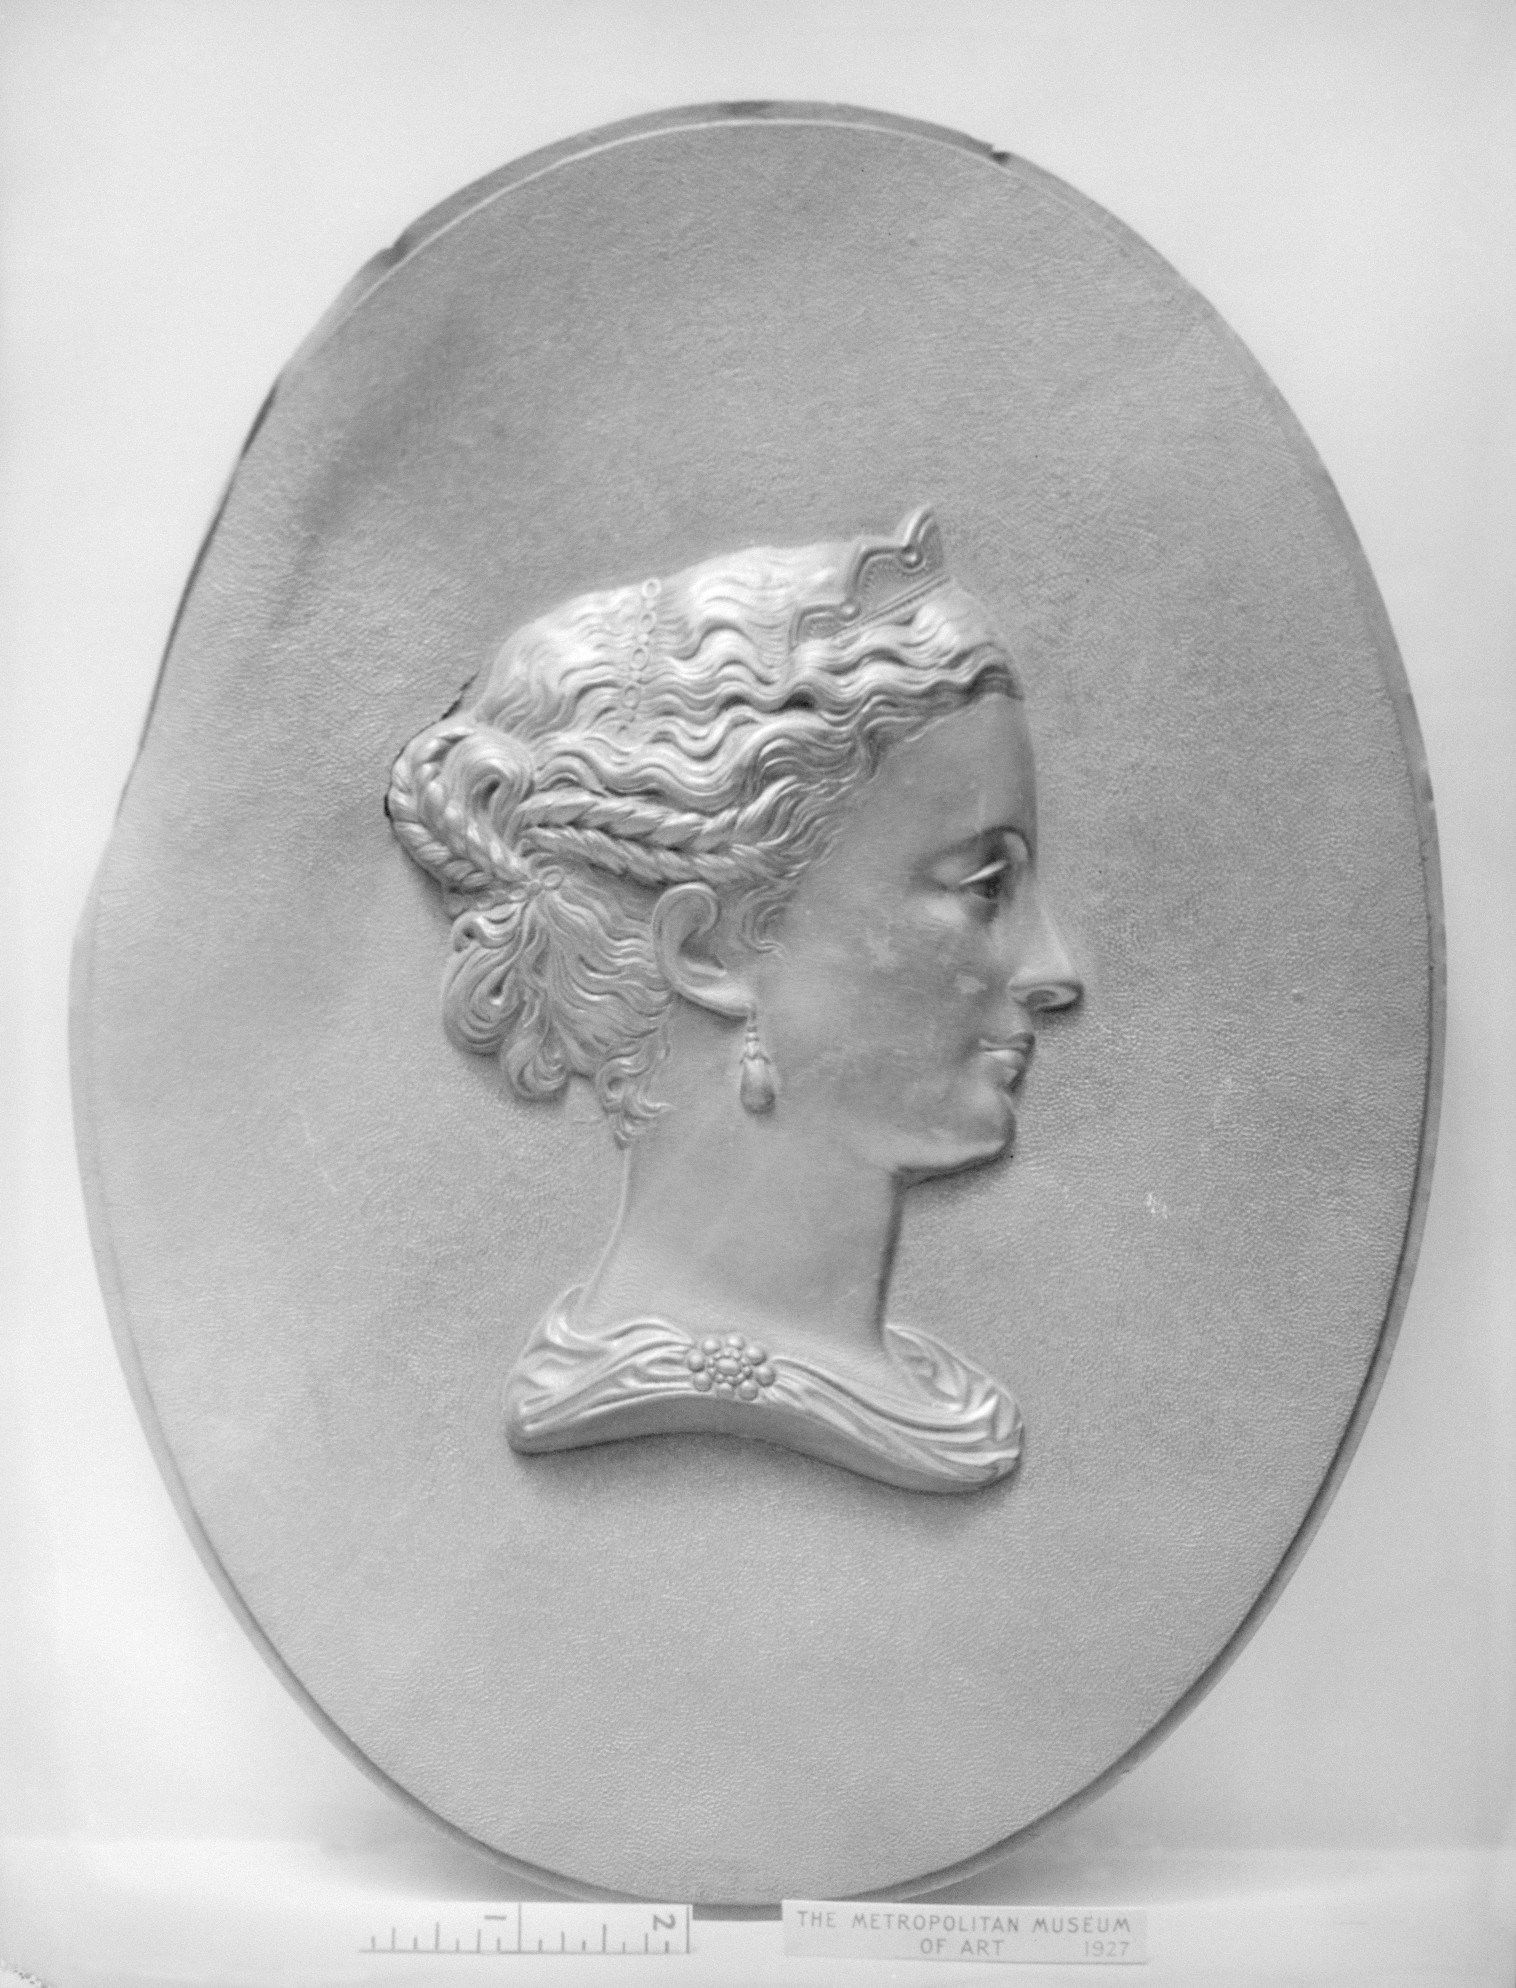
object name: medallion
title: Head of a woman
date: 1801-1900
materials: copper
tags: heads,profiles,women